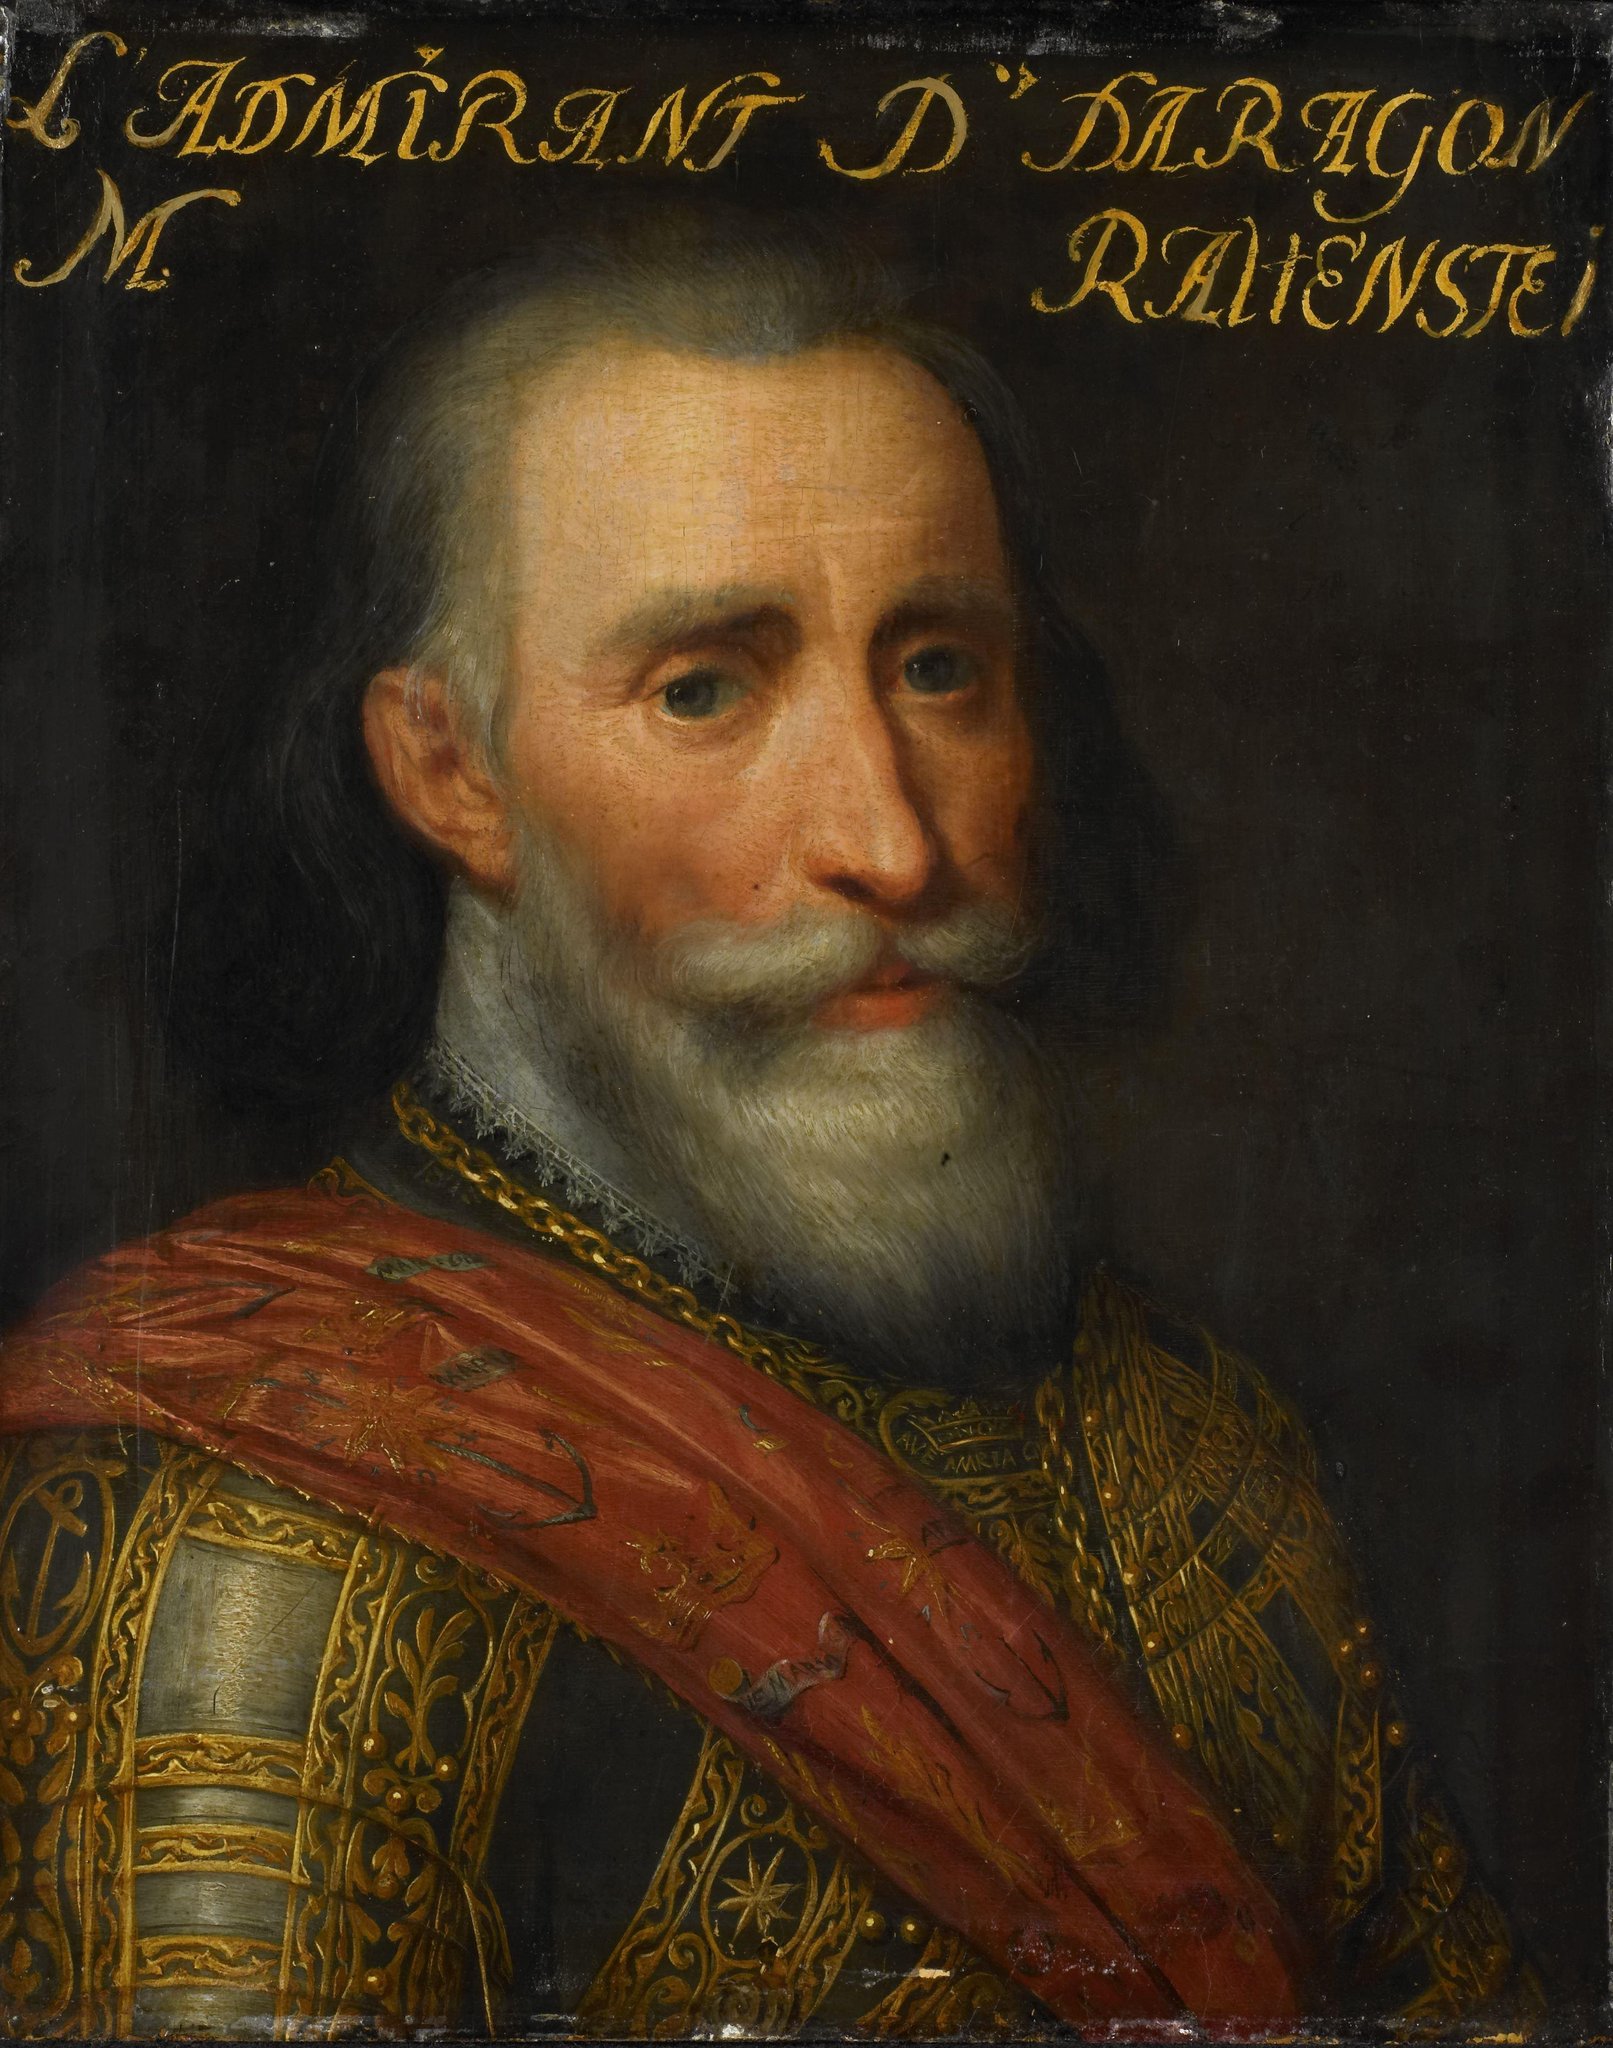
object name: painting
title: Portrait of Francisco Hurtado de Mendoza (1546-1623)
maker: jan antonisz van ravesteyn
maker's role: draughtsman, painter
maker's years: 1570-1657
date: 1609-1633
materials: oil, panel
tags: historical persons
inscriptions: inscription, top: ‘L'ADMIRANT D'DARAGON/ M. RAVENSTEIN’, inscription, upper right: ‘L'admirant d'ara/gon./M. ravenstein’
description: Franciso Hurtado de Mendoza (1546-1623), naar J.A. van Ravesteyn.